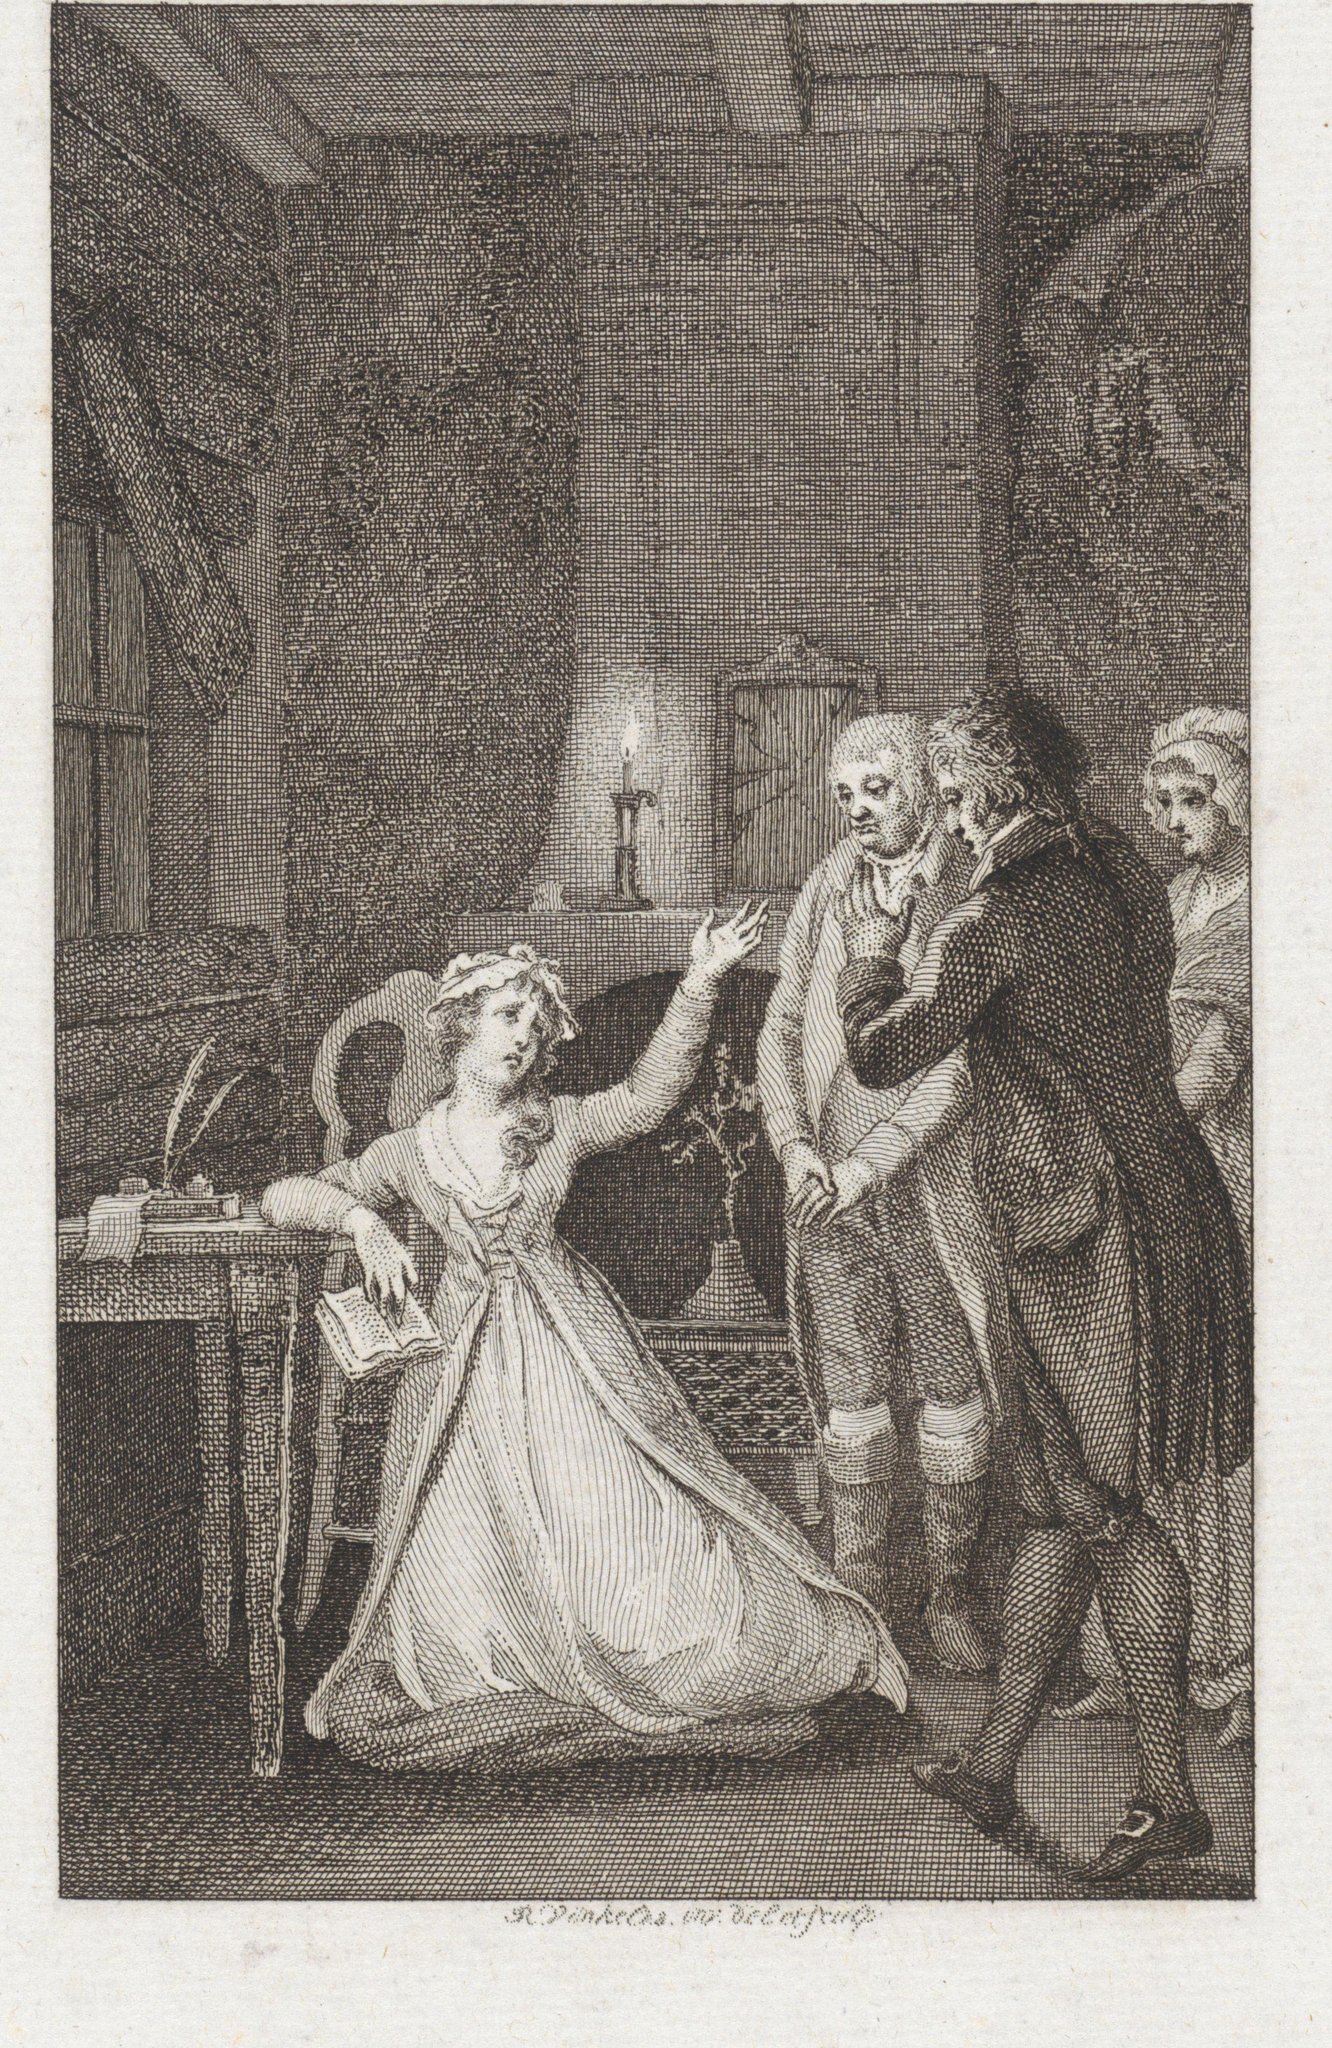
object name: print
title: Vrouw stuurt een man weg uit haar kamer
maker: reinier vinkeles (i)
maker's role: draughtsman, print maker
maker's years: 1741-1816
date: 1803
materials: paper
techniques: engraving, etching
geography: amsterdam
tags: chimney, writing tools, despair; 'disperatione' (ripa), ruin of a dwelling, house, castle, etc.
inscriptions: collector's mark: Lugt 240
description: In een bouwval vraagt een wanhopige vrouw of de man in haar kamer weg wil gaan. Ze zit naast een schrijftafel met een boek in de hand. Twee andere figuren staan er gelaten bij.